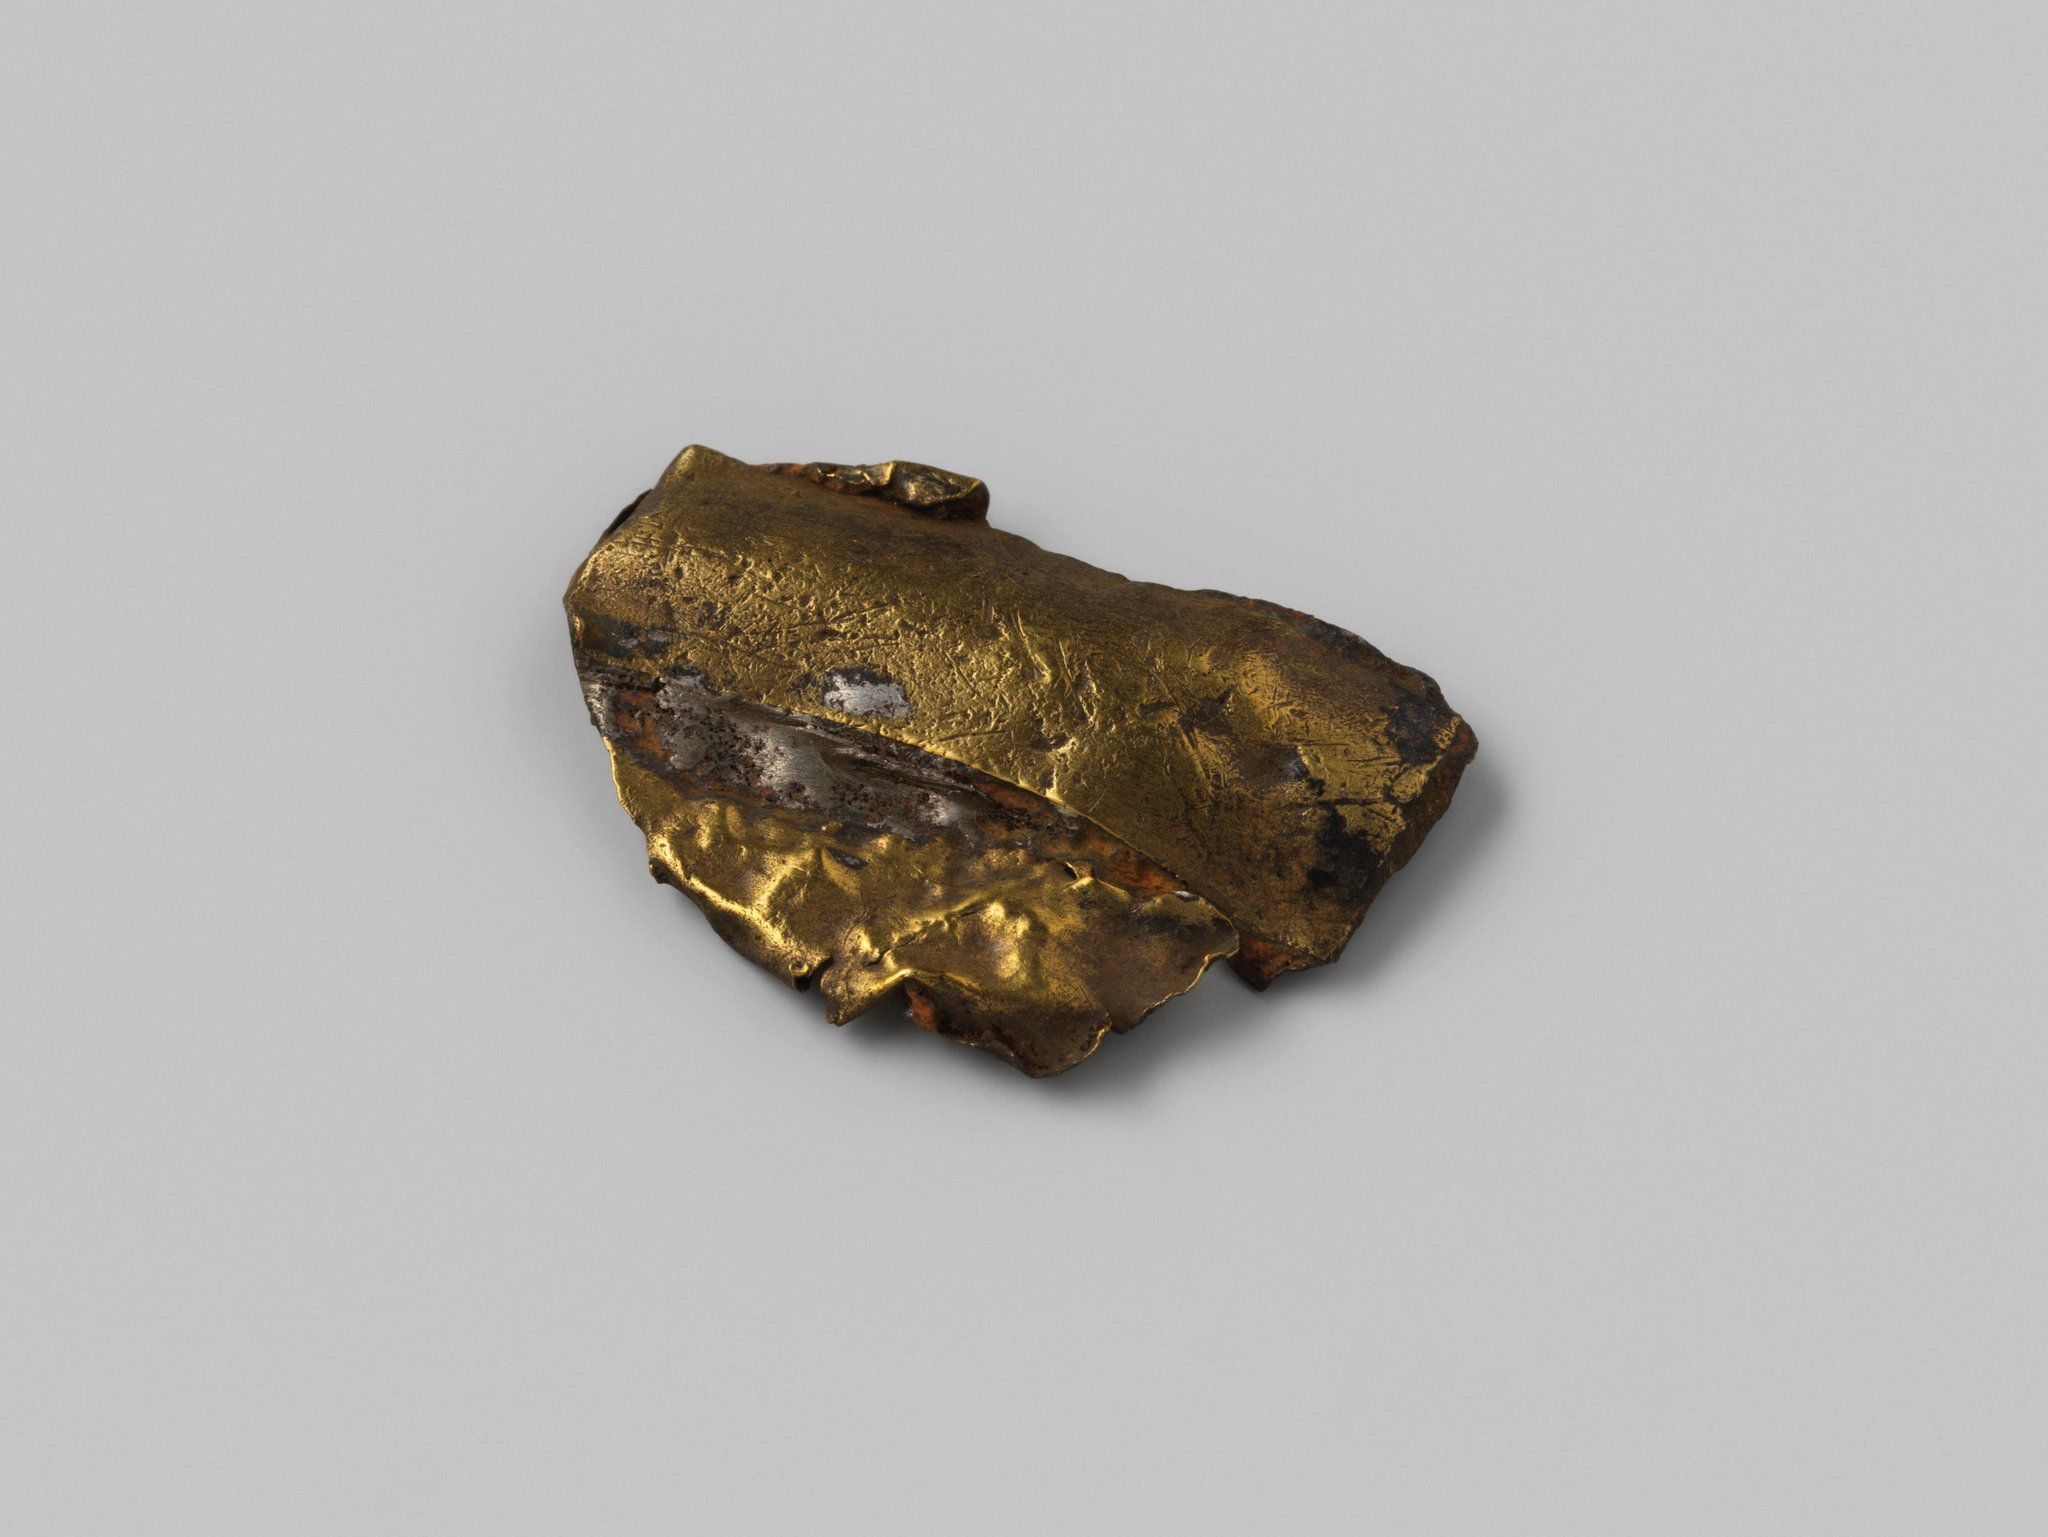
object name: fragment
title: Fragment uit het wrak van de Oost-Indiëvaarder Hollandia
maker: Anonymous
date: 1700-1743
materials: copper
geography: netherlands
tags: verenigde oostindische compagnie, hollandia (schip), annet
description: Varied parts or fragments, sheet metal fragments: worked, with solder; fragm of sheet, eroded, with soldered band, curved in section.